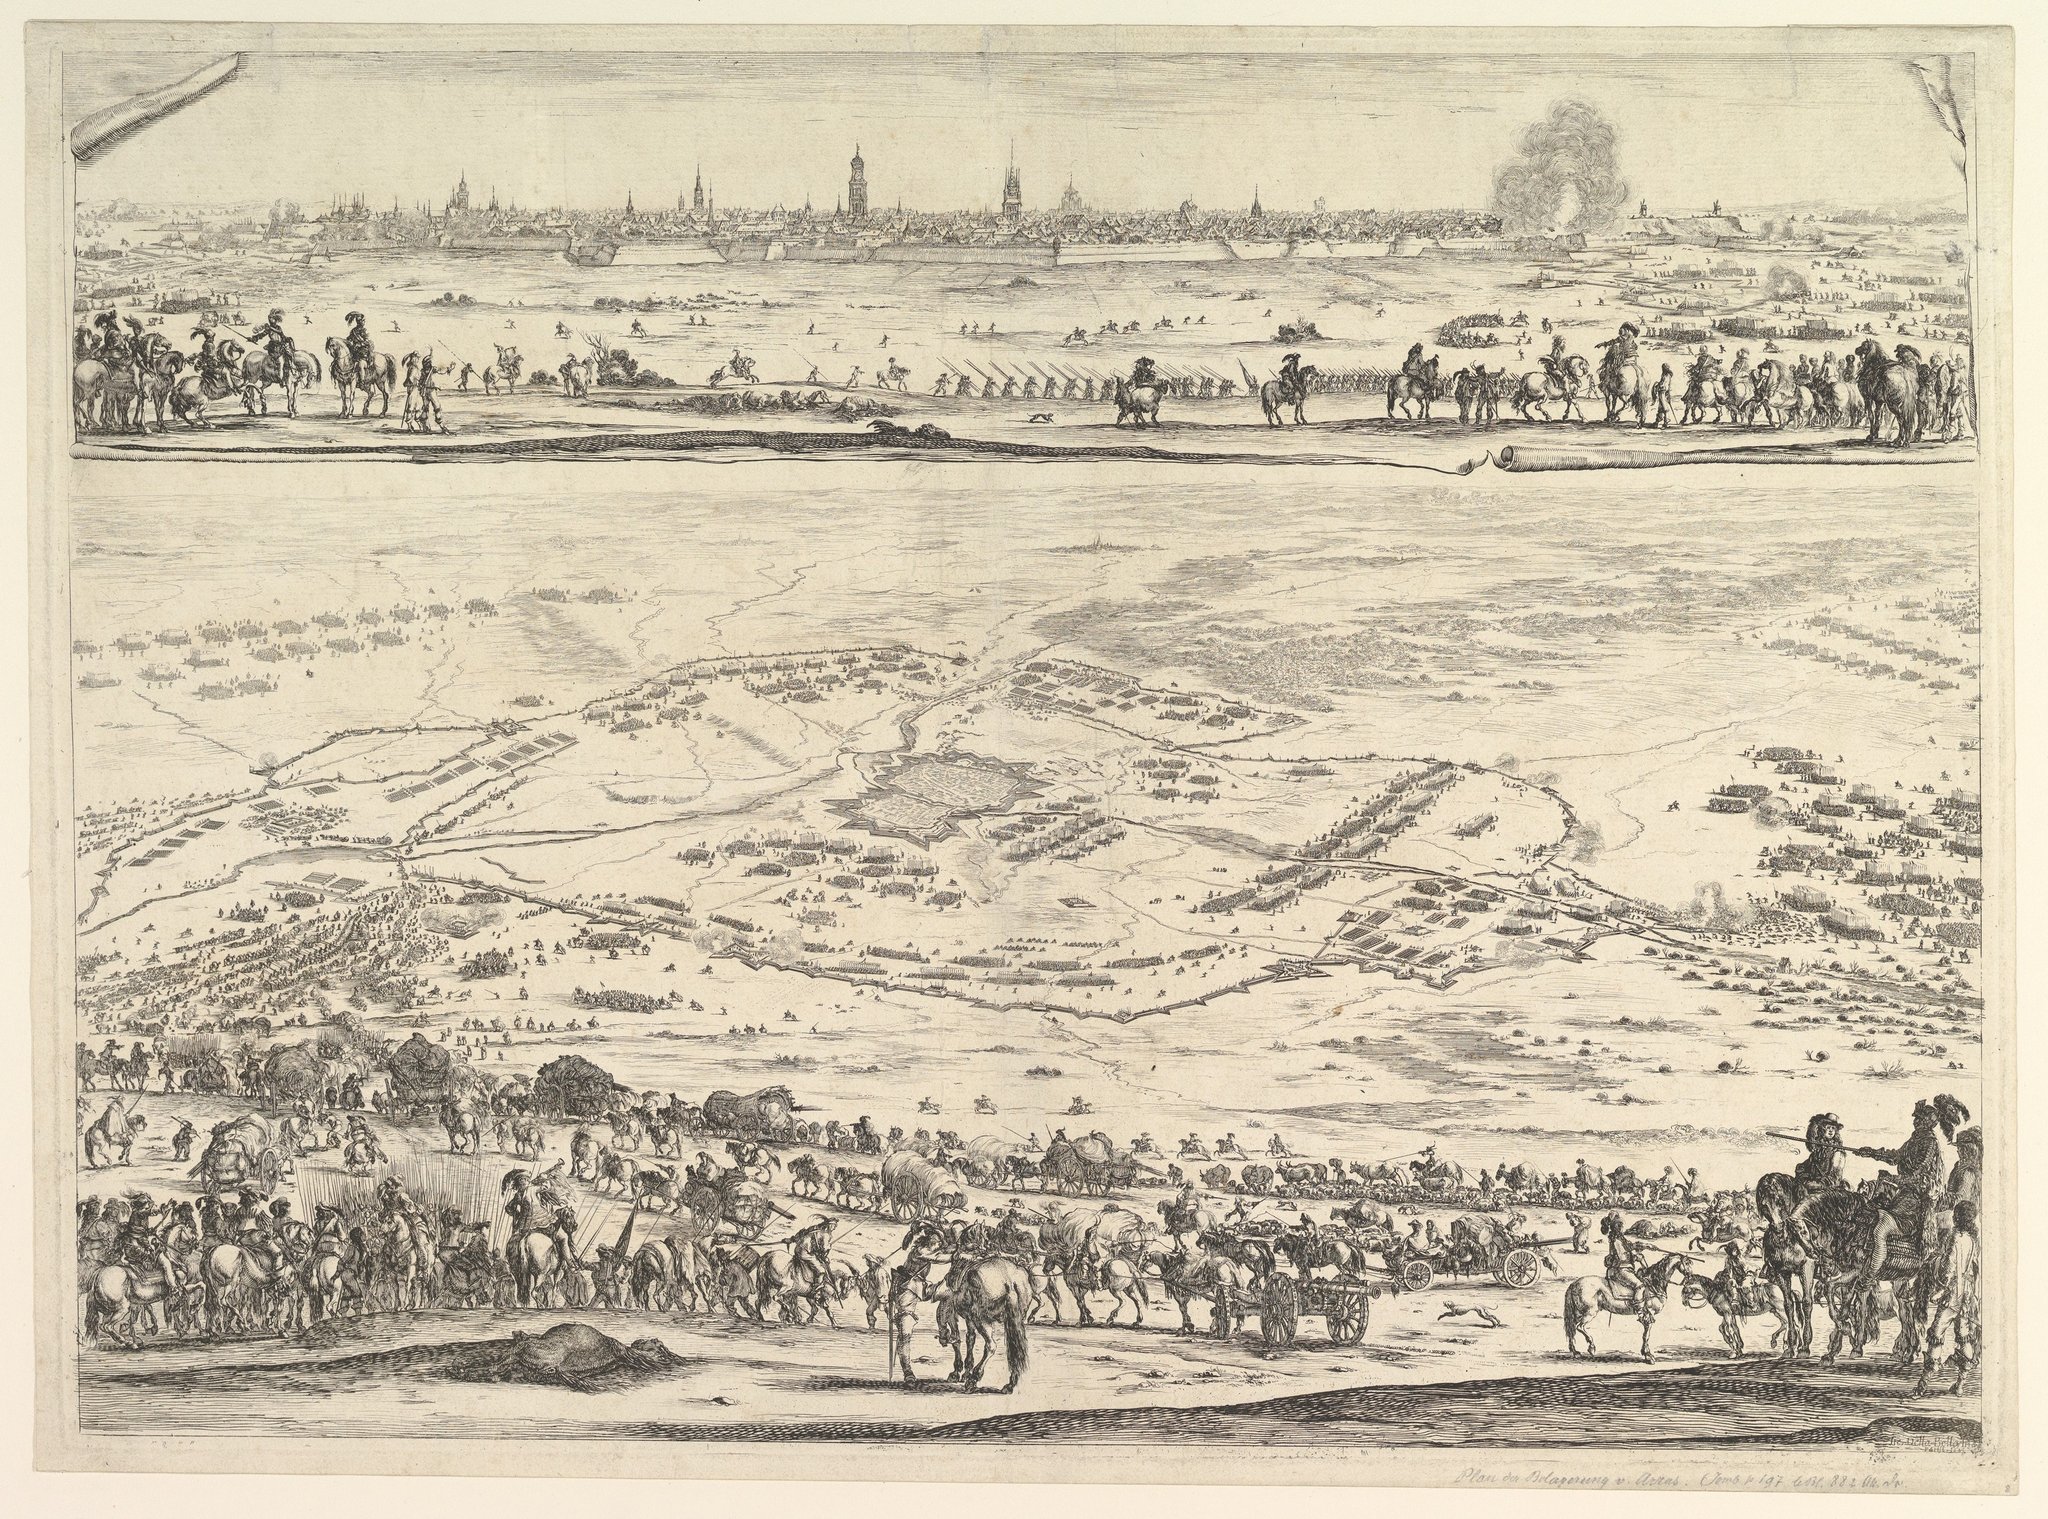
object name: print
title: Plan and view of the siege of Arras: lower part of the plate with a topographical view with troops in the foreground descending a hill, upper part of the plate with a view of the town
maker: stefano della bella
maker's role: artist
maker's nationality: italian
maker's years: 1610-1664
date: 1641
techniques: etching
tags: human figures,towns,horses